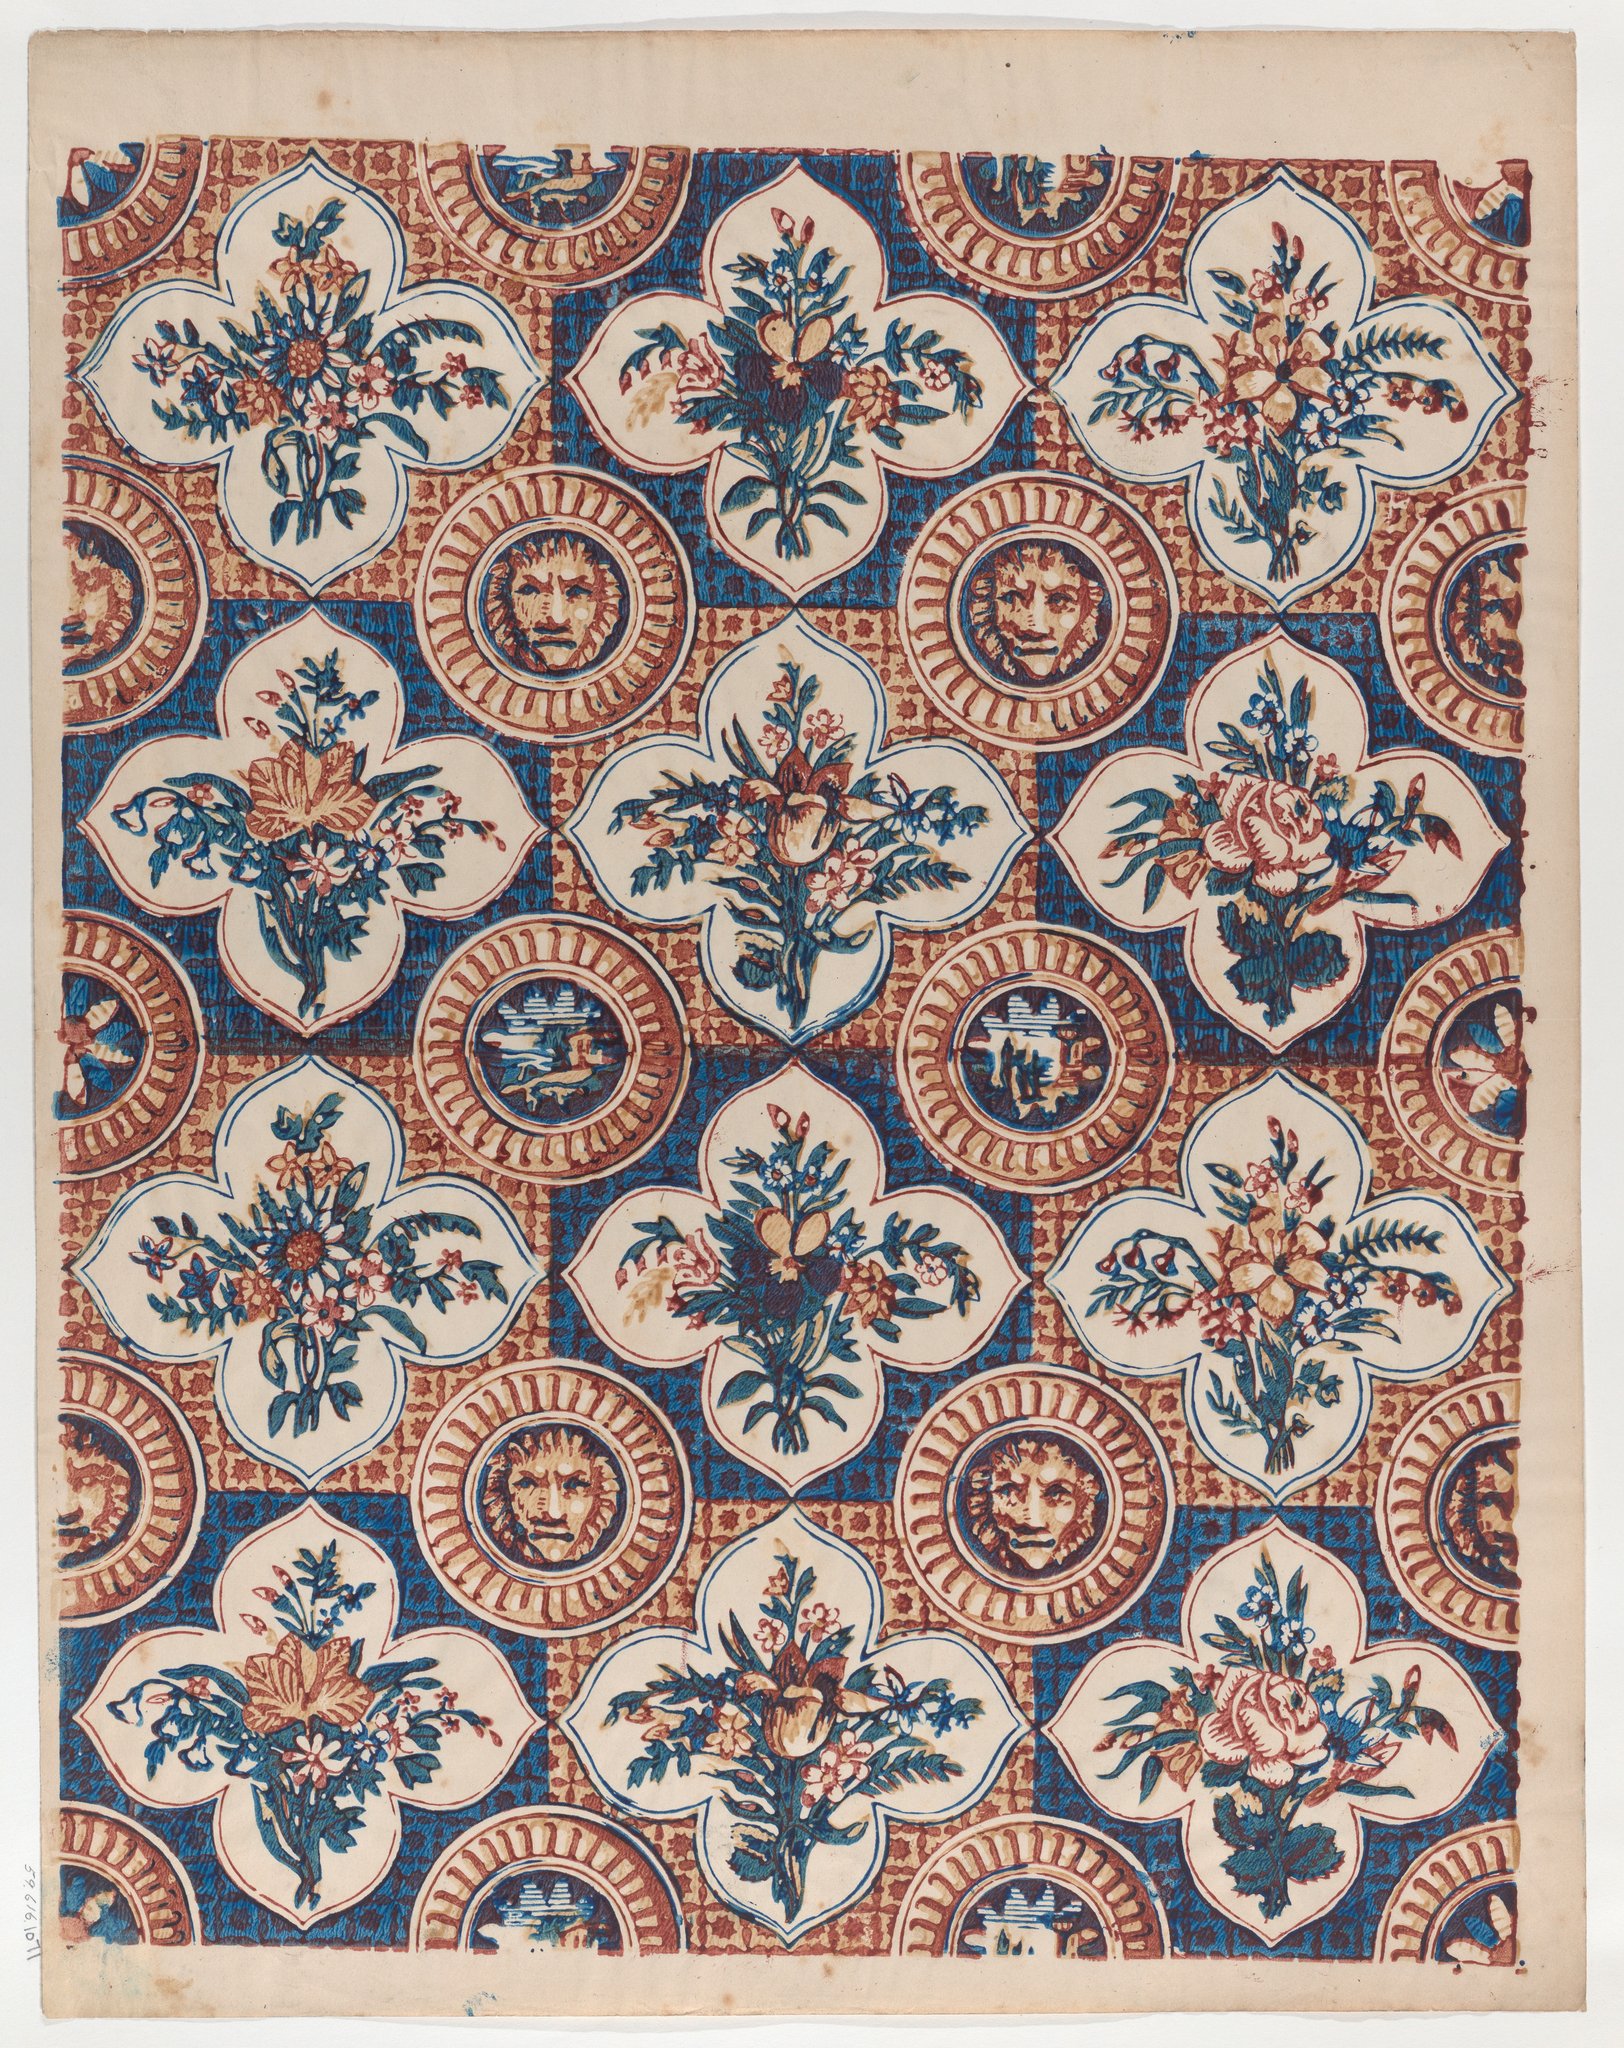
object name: print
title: Sheet with pattern of bouquets and lion heads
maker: Anonymous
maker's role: artist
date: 1767-1866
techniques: relief print